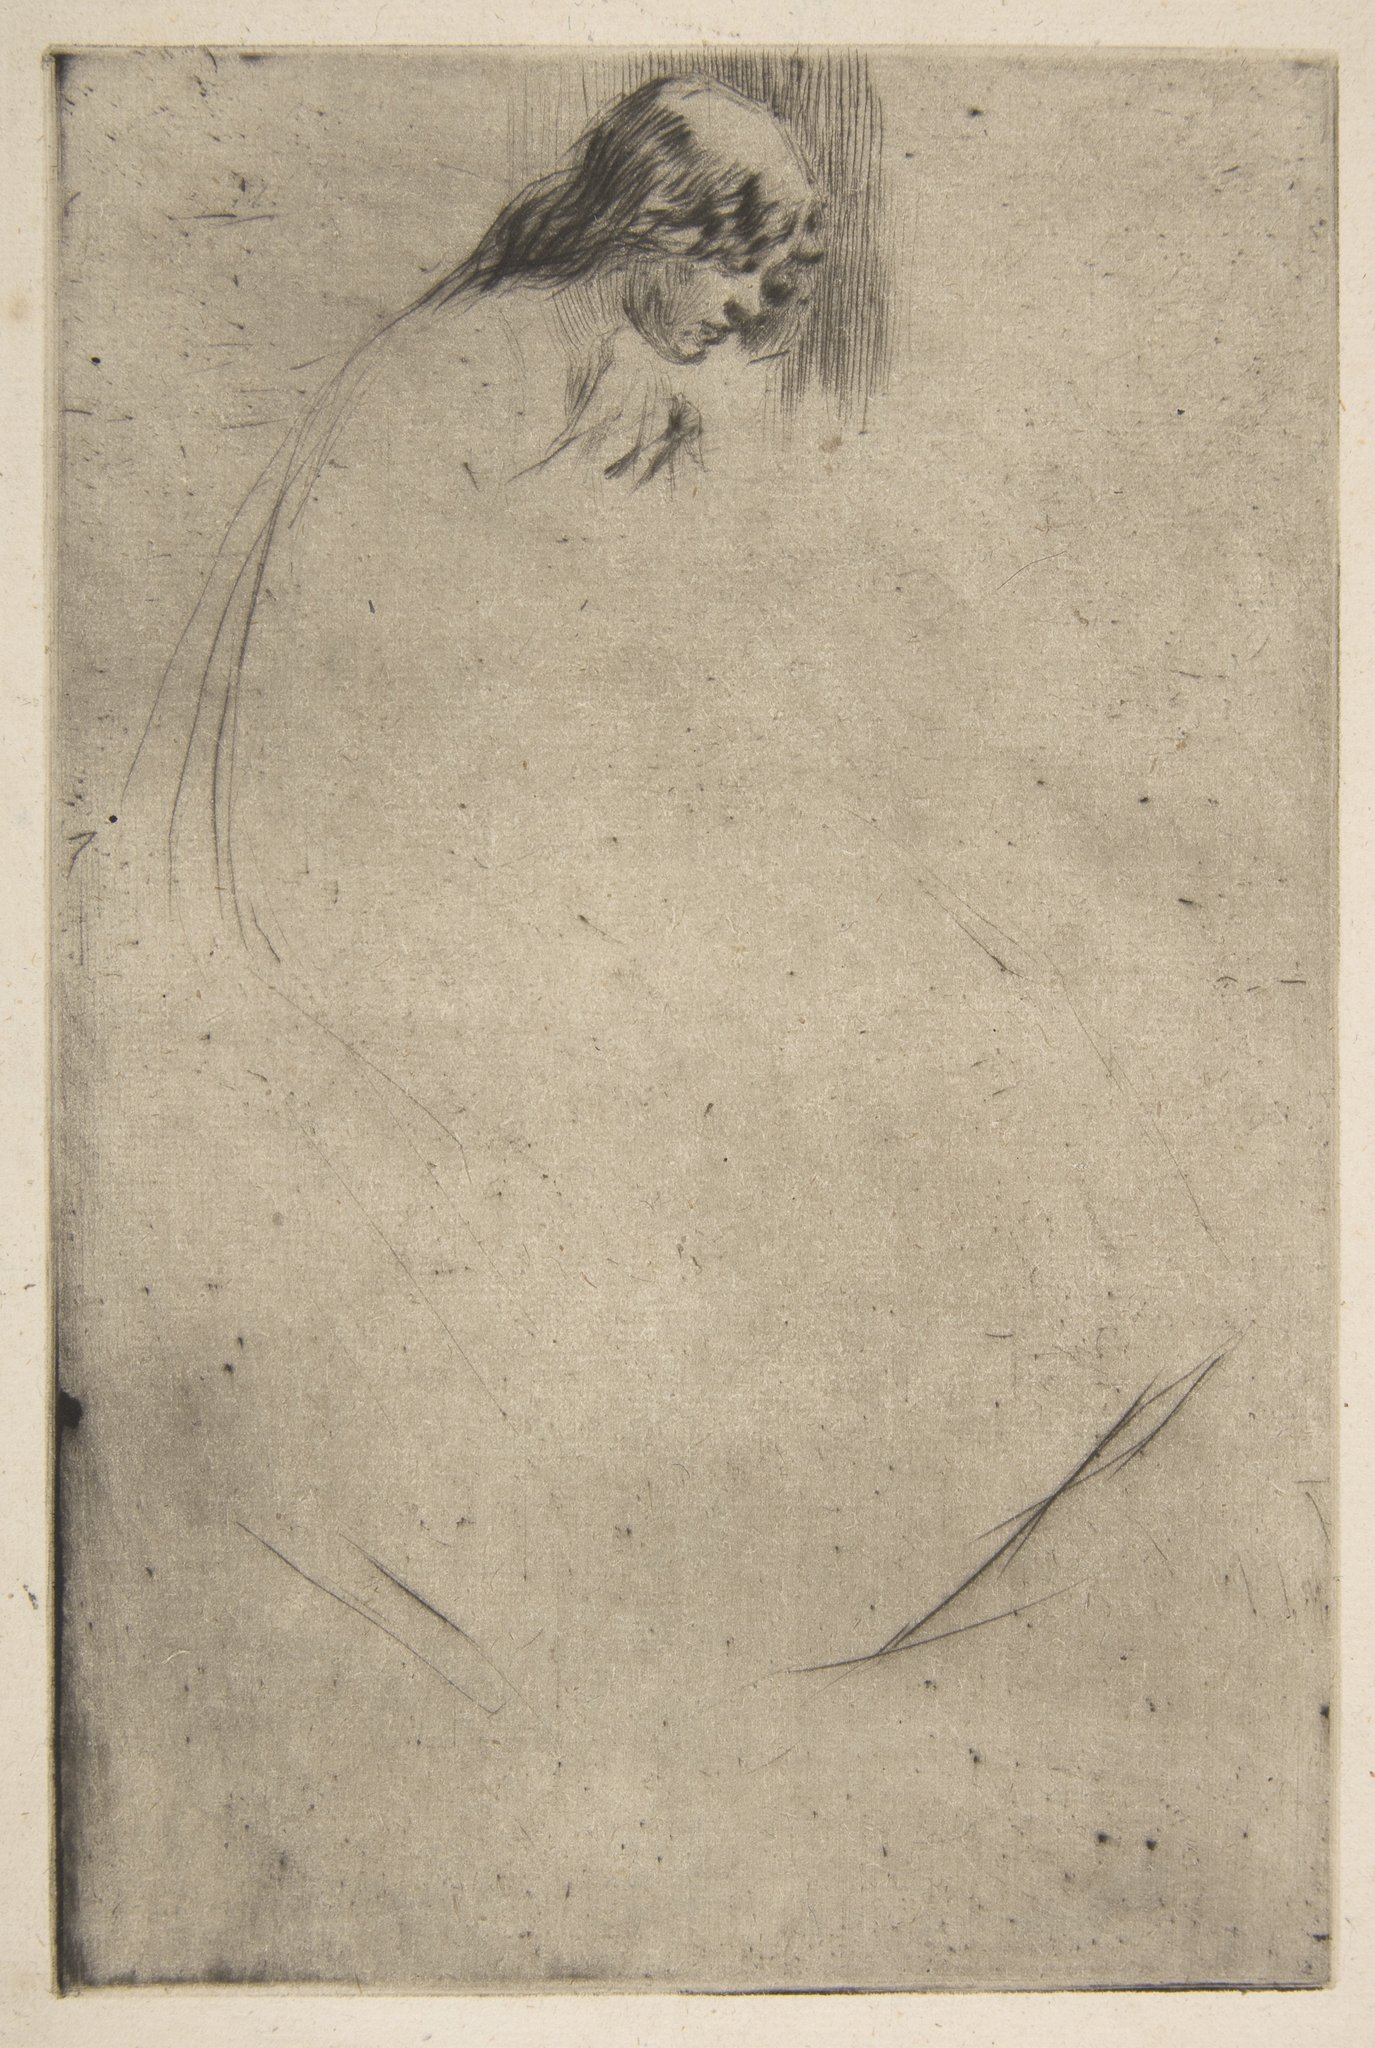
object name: print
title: Jo's Bent Head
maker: james mcneill whistler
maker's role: artist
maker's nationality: american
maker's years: 1834-1903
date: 1861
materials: ink, paper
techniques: drypoint, printing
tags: heads,women